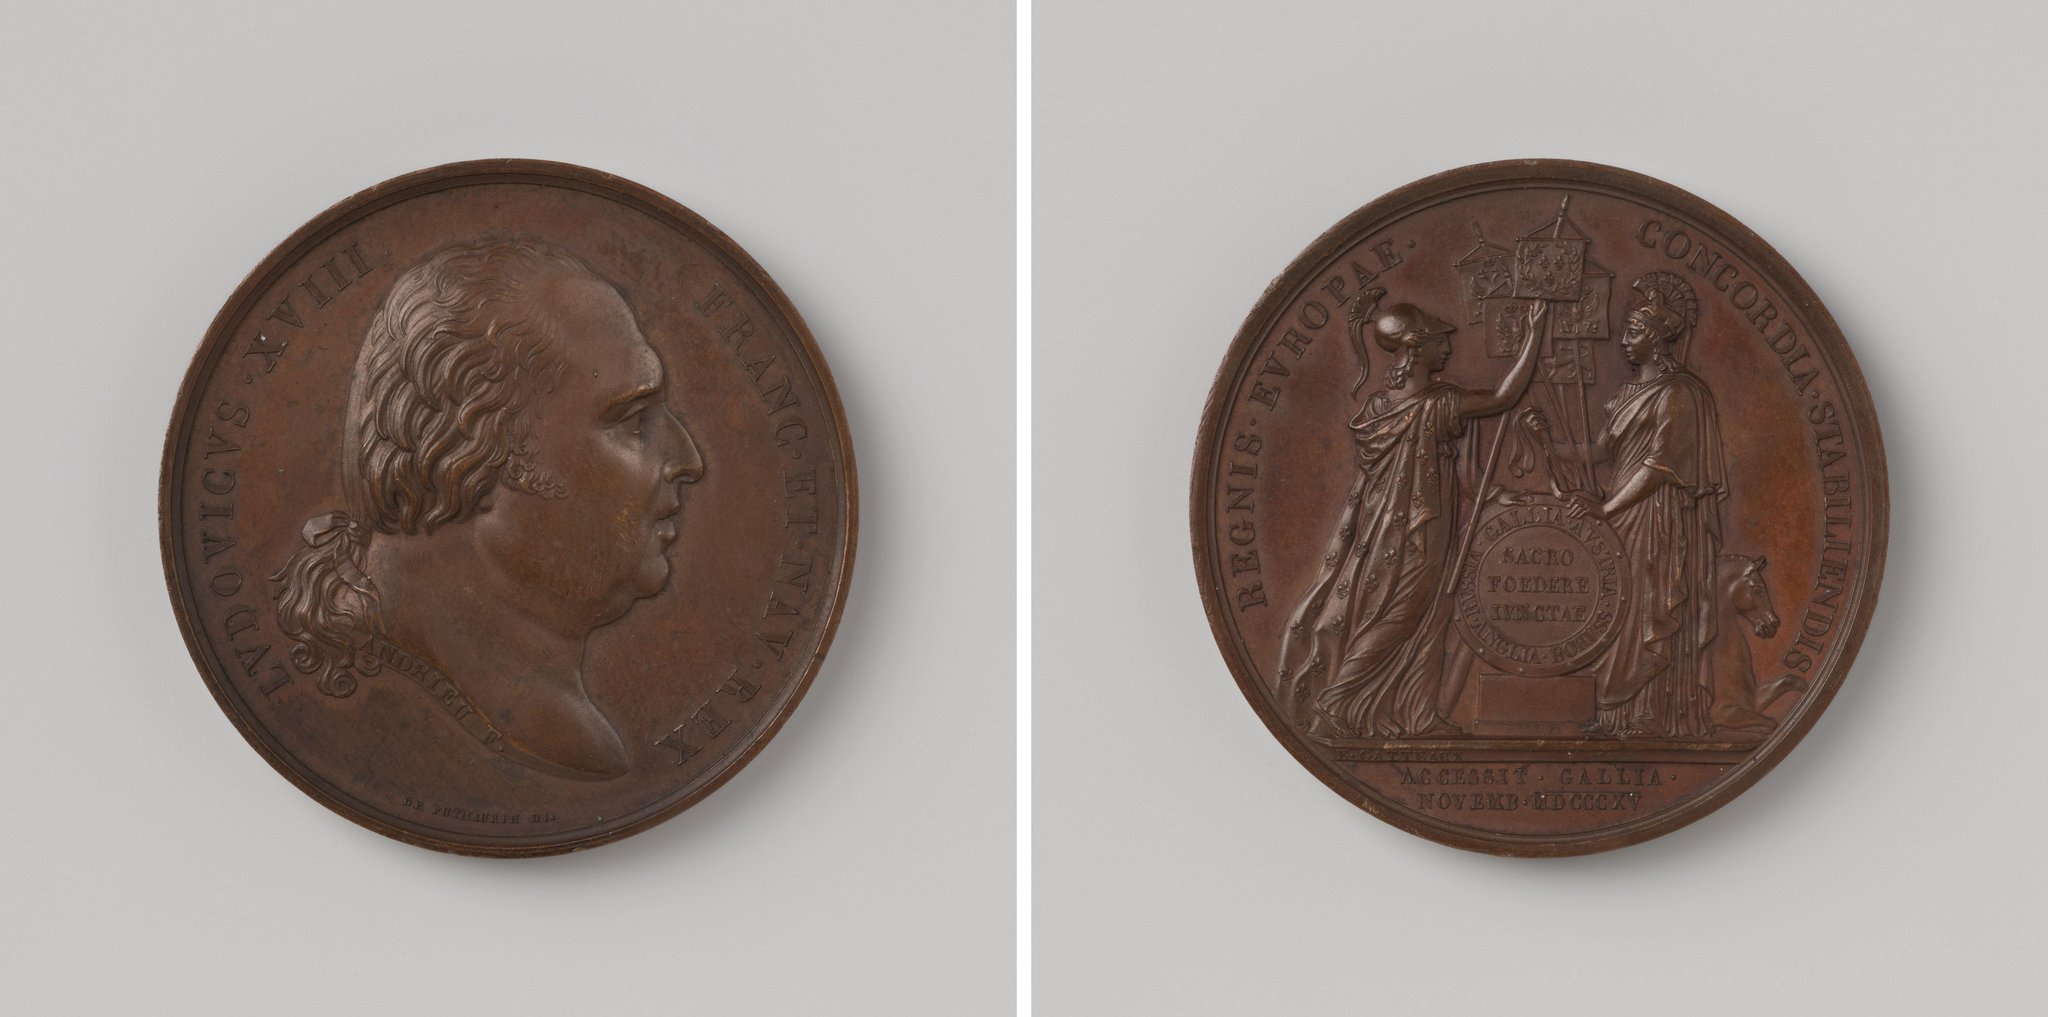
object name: history medal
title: Heilig Verbond en de tweede vrede van Parijs, ter ere van Lodewijk XVIII, koning van Frankrijk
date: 1815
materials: bronze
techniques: striking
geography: paris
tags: lodewijk xviii (koning van frankrijk), paris